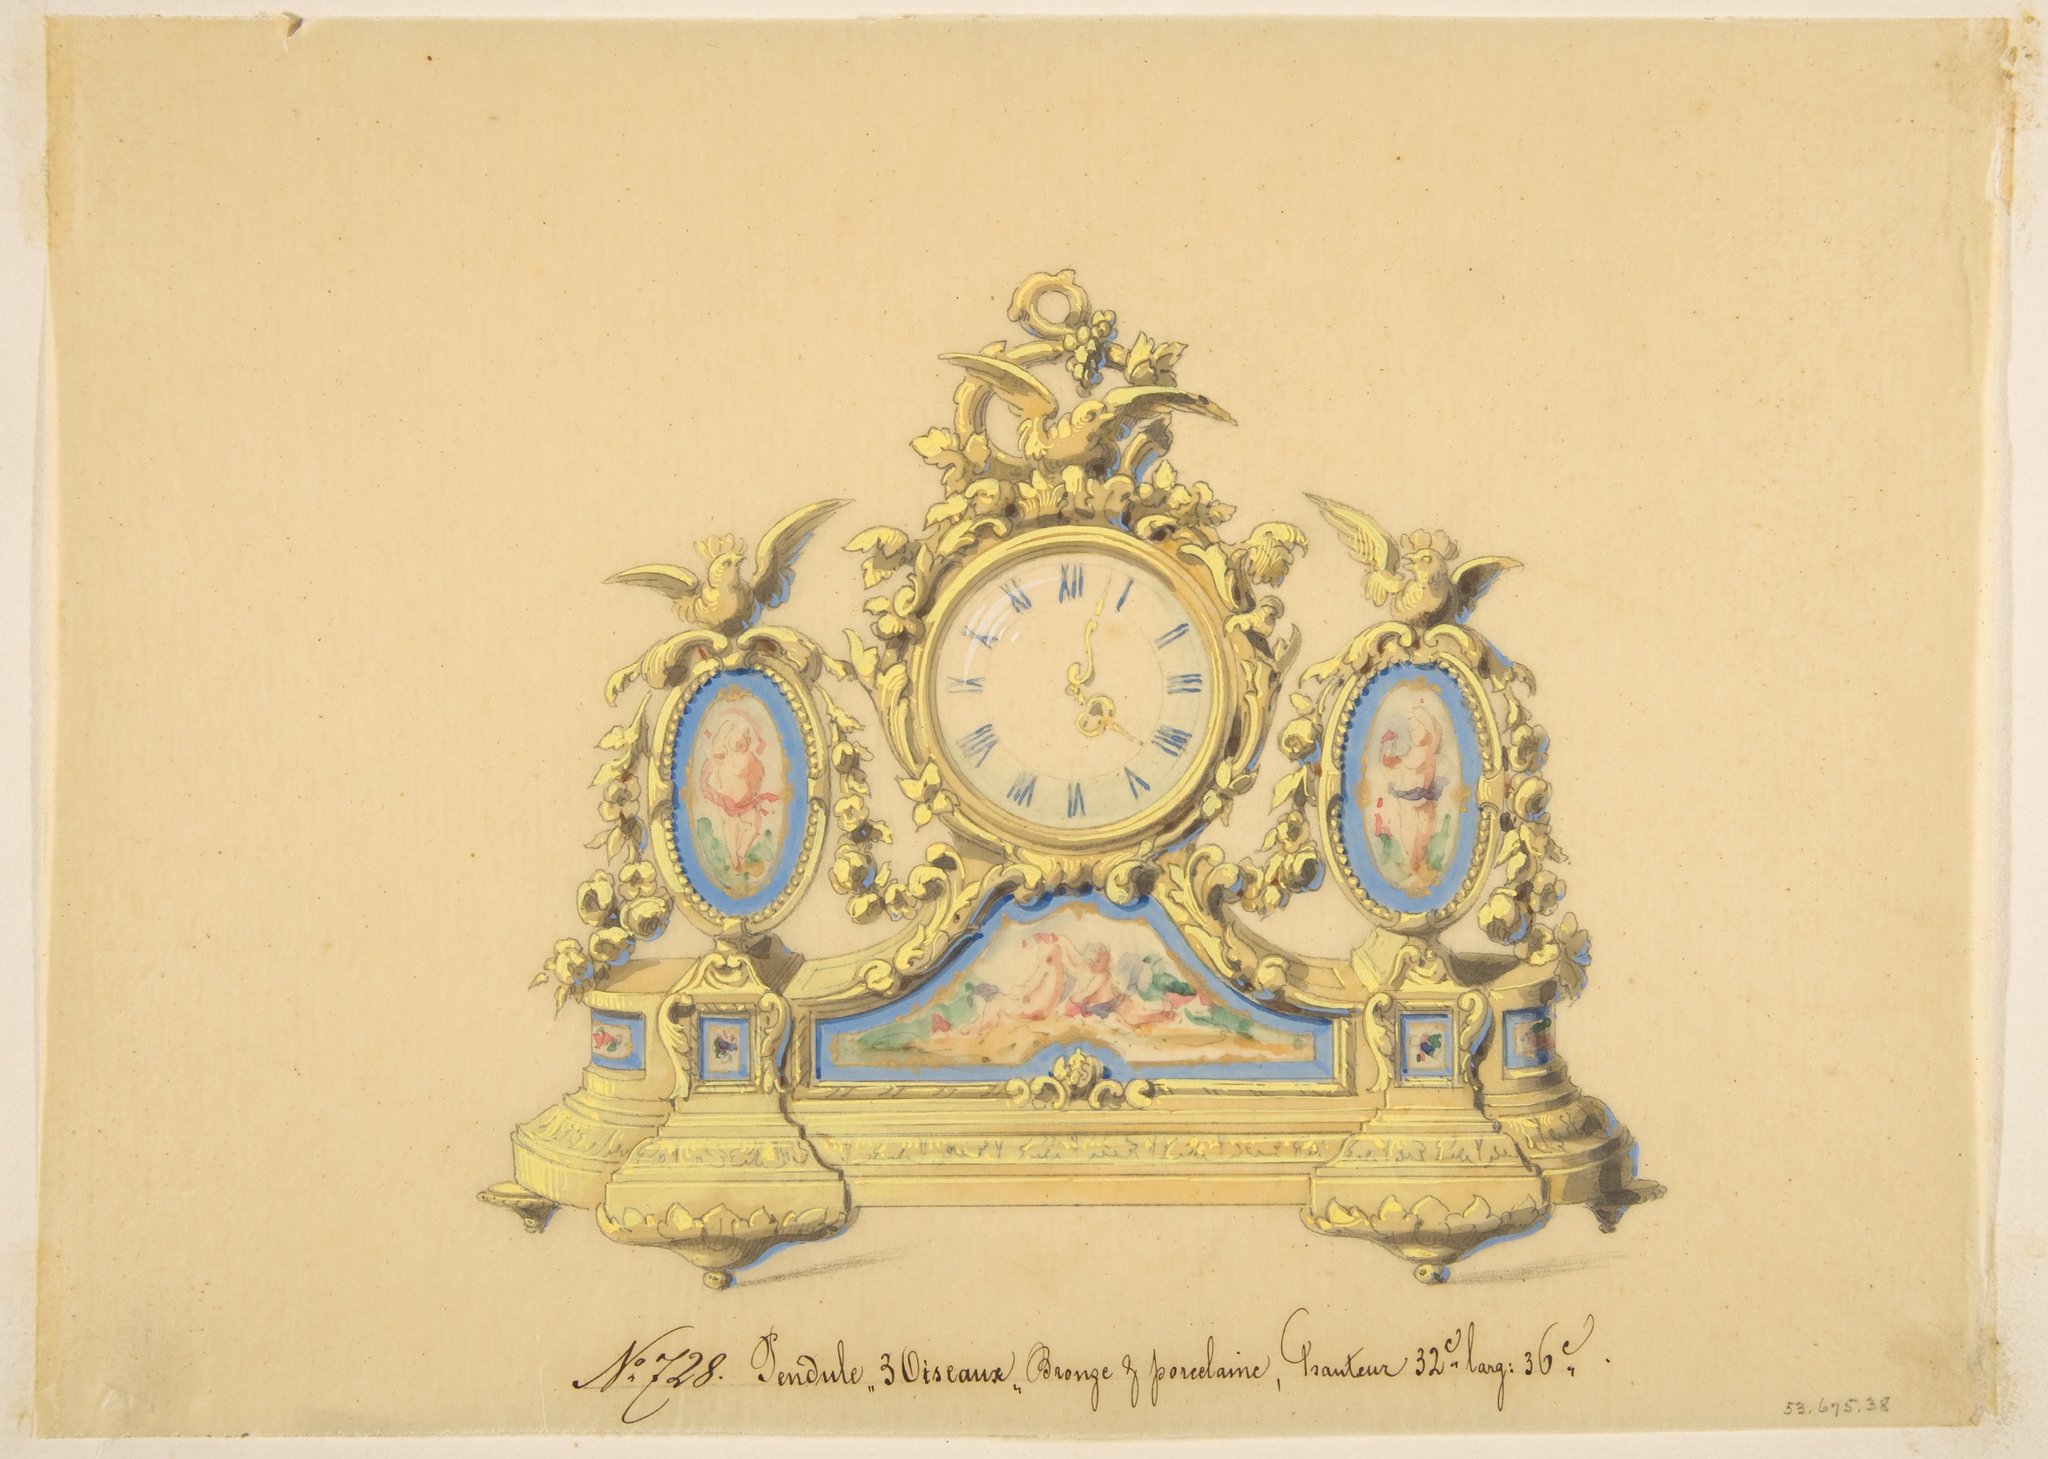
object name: drawing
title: Design for a Clock: Three Birds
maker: anonymous, french, 19th century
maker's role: artist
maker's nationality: french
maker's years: 1800-1900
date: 1801-1900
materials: gilt, gold, gouache, graphite, watercolor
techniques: brush, wash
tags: clocks